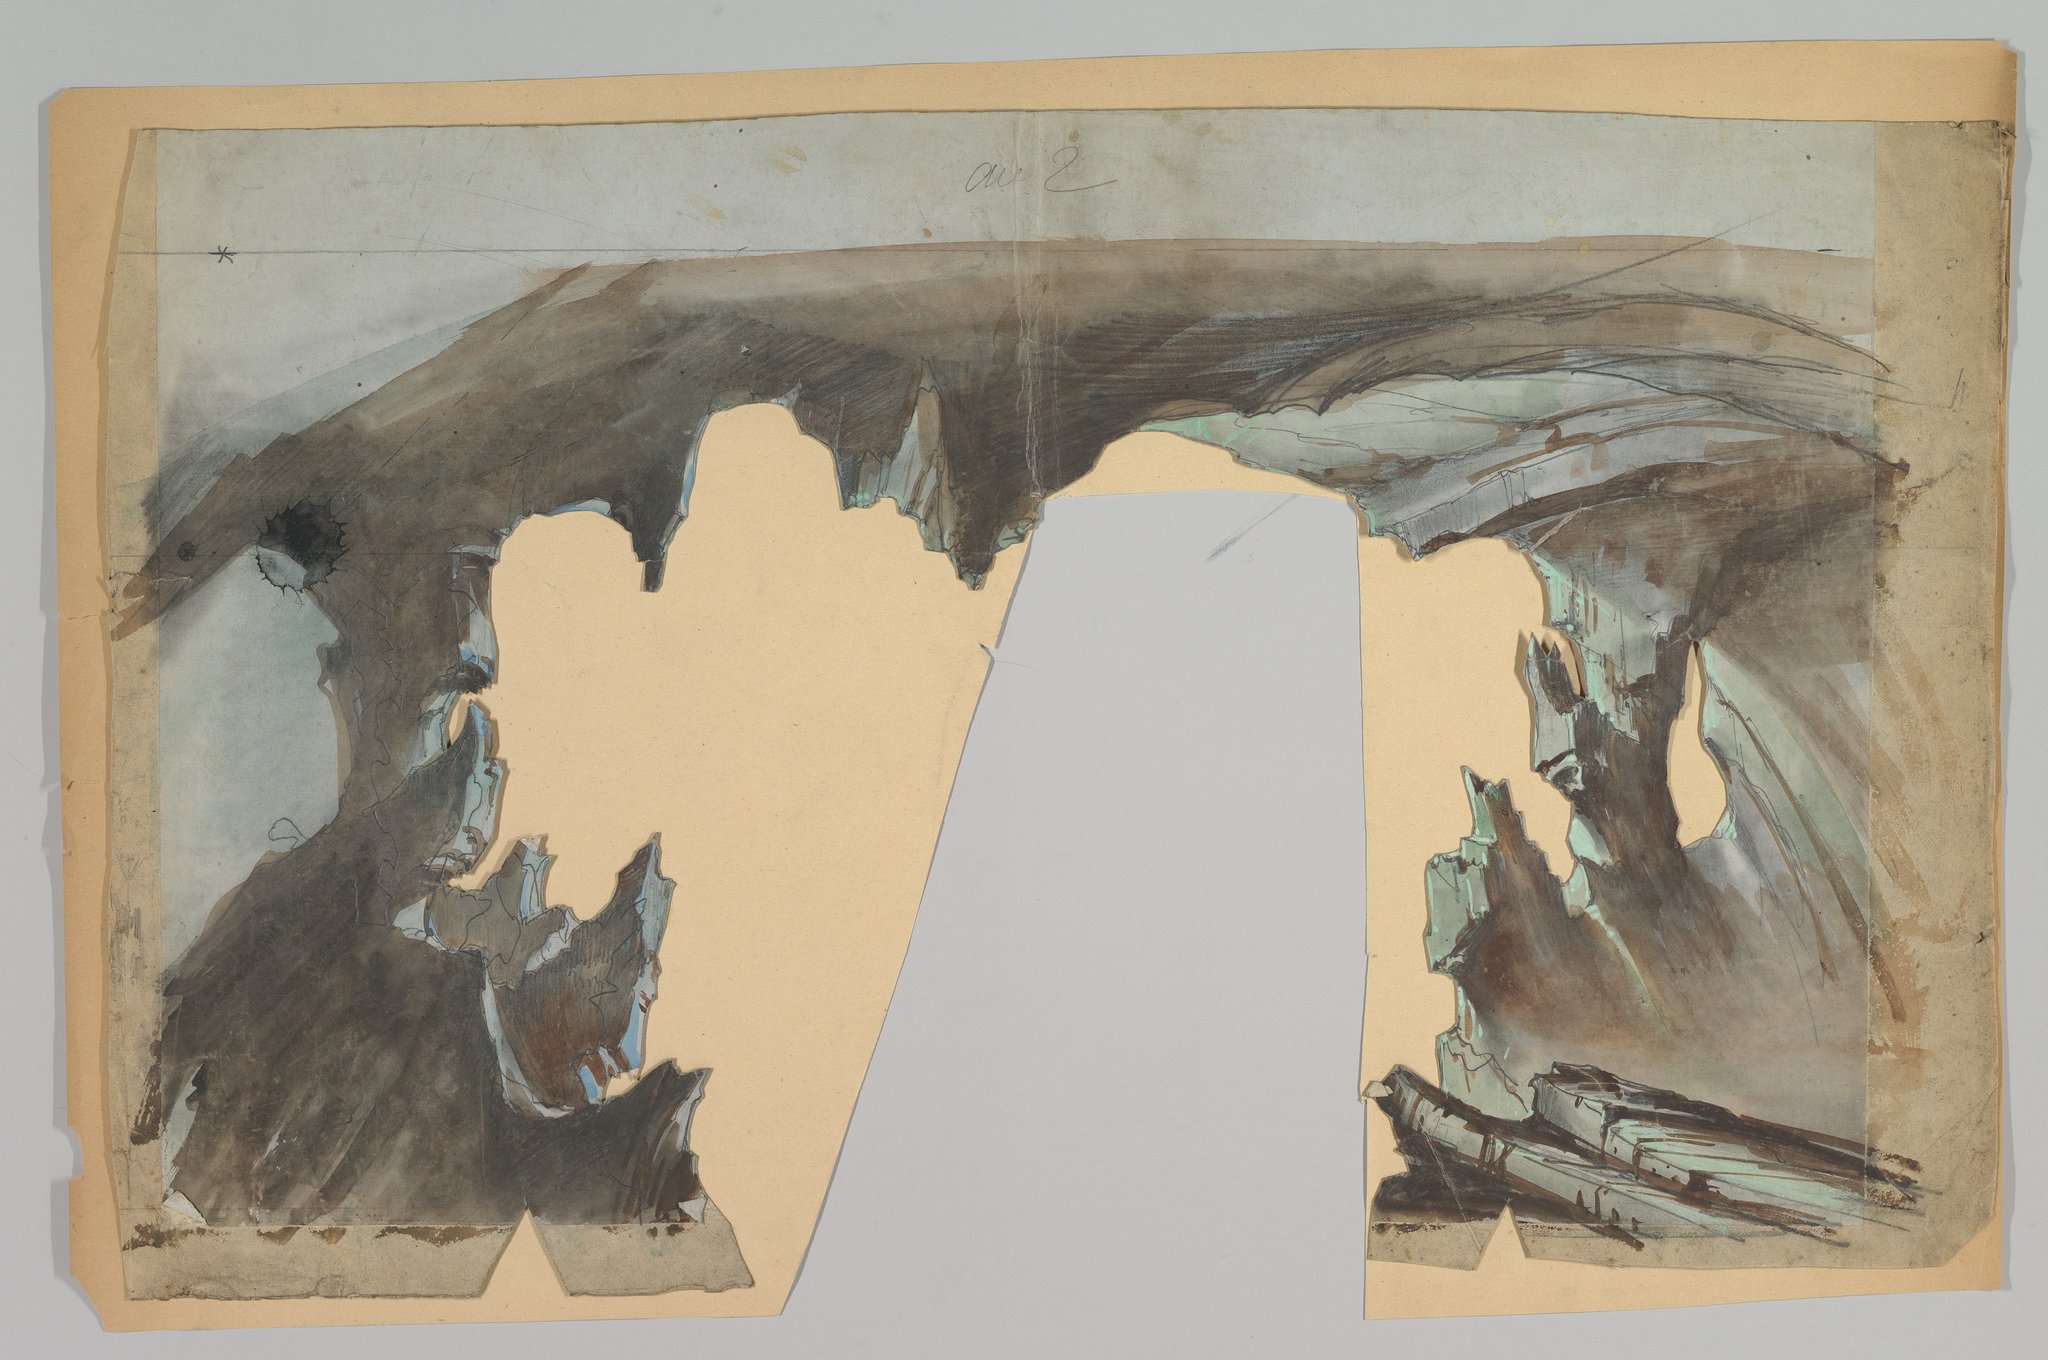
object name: drawing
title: Design for a Stage Set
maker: eugène cicéri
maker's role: artist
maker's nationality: french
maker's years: 1813-1890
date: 1830-1890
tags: stage design